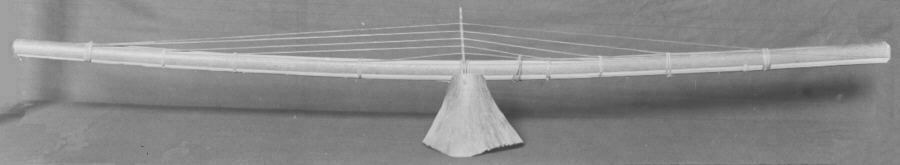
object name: mvet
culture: fang people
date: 1867-1900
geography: gabon